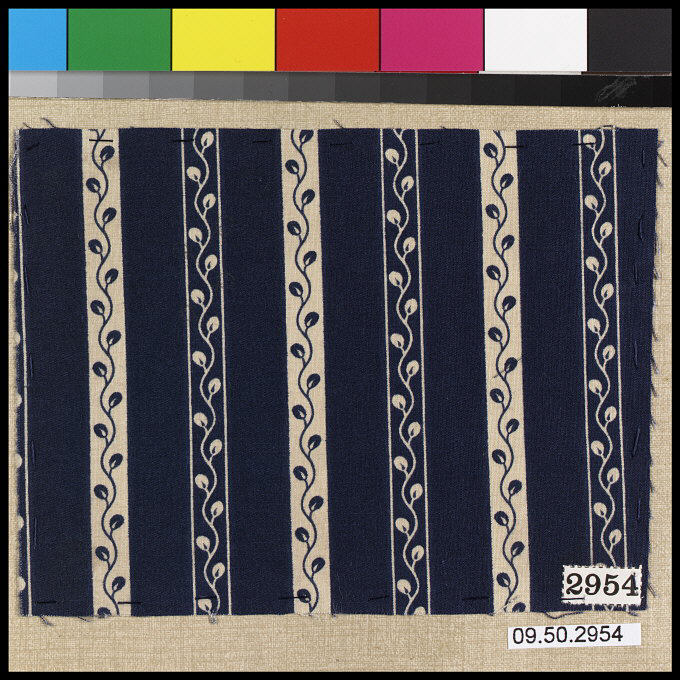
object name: piece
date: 1801-1900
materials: cotton